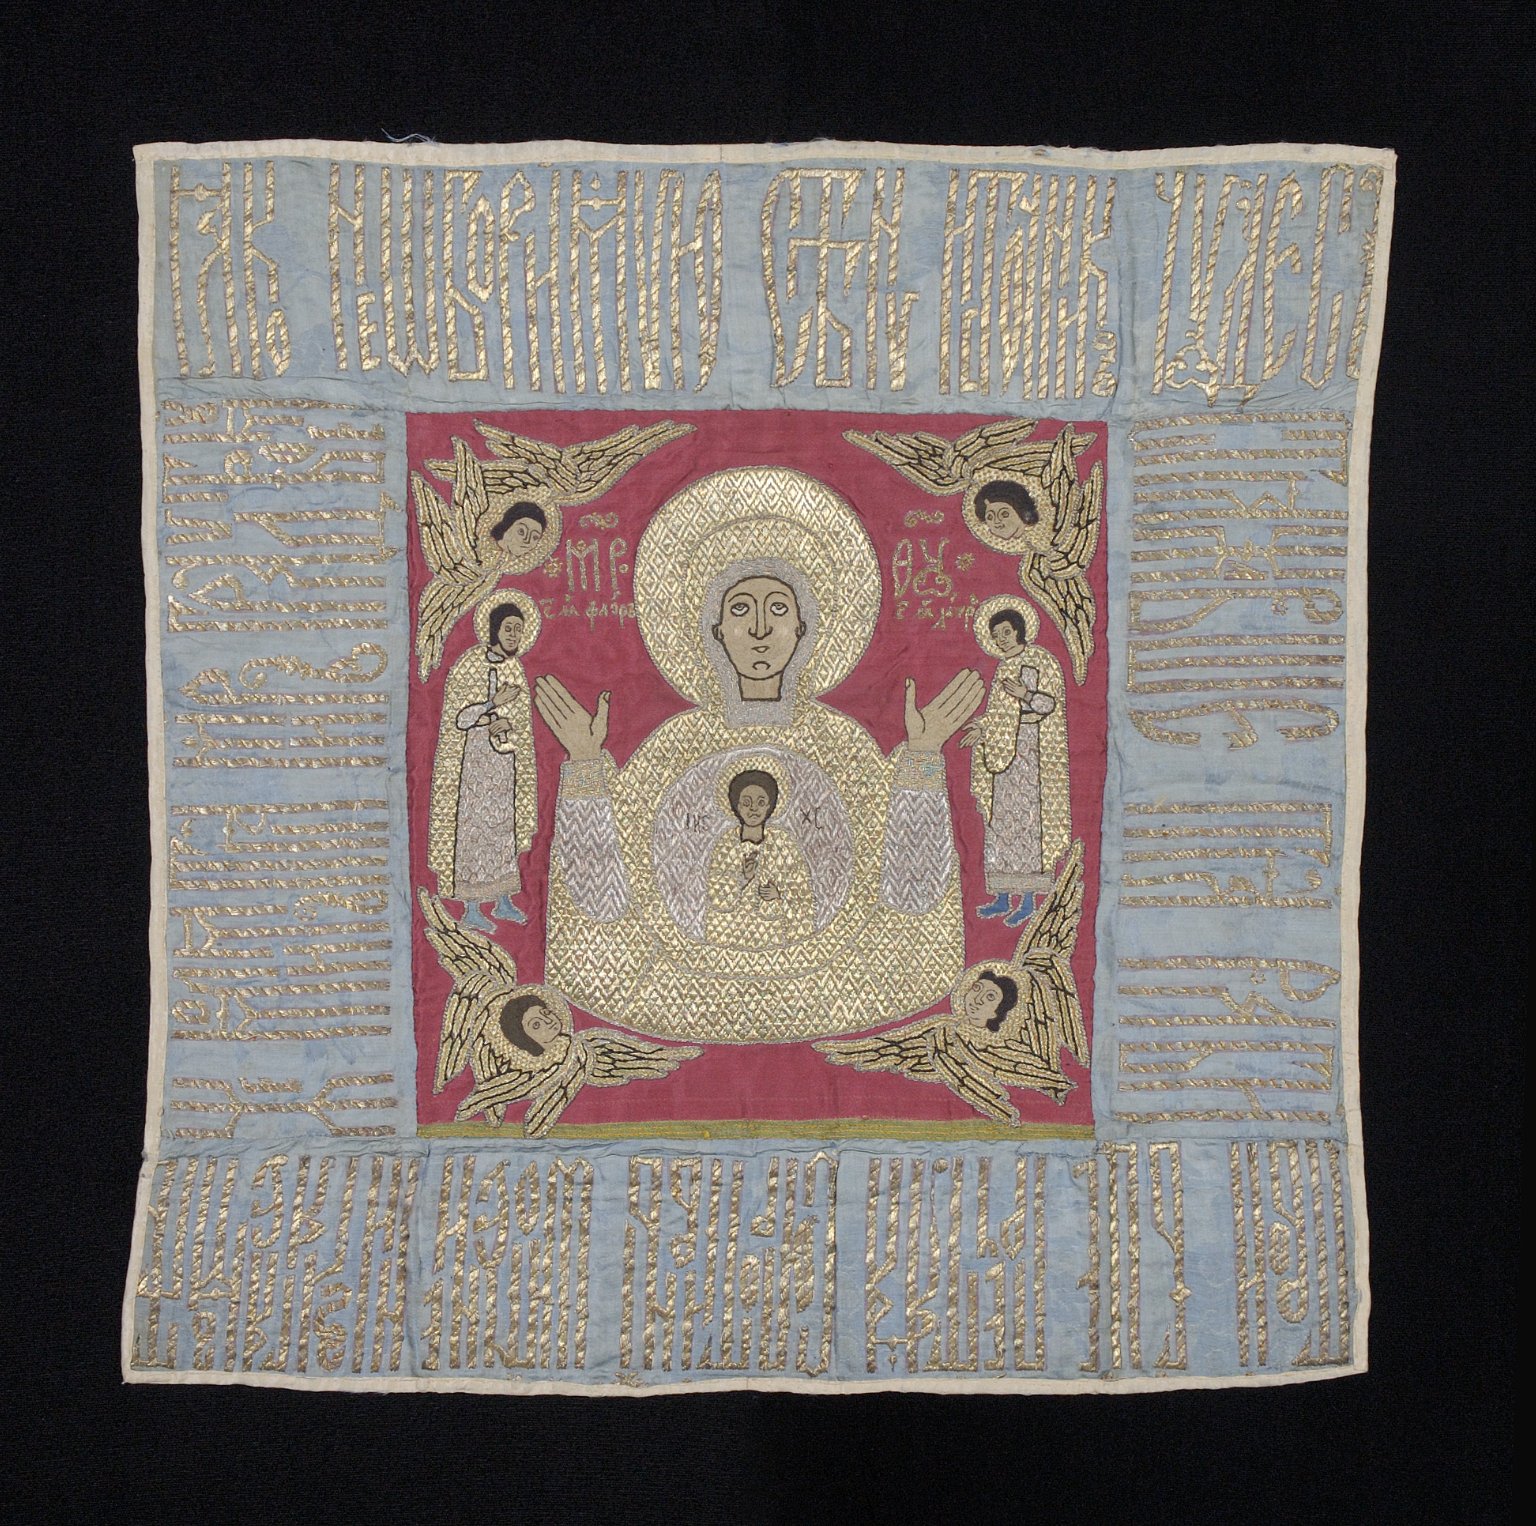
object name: chalice cover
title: Chalice veil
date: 1501-1600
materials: cotton, silk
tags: angels,virgin mary